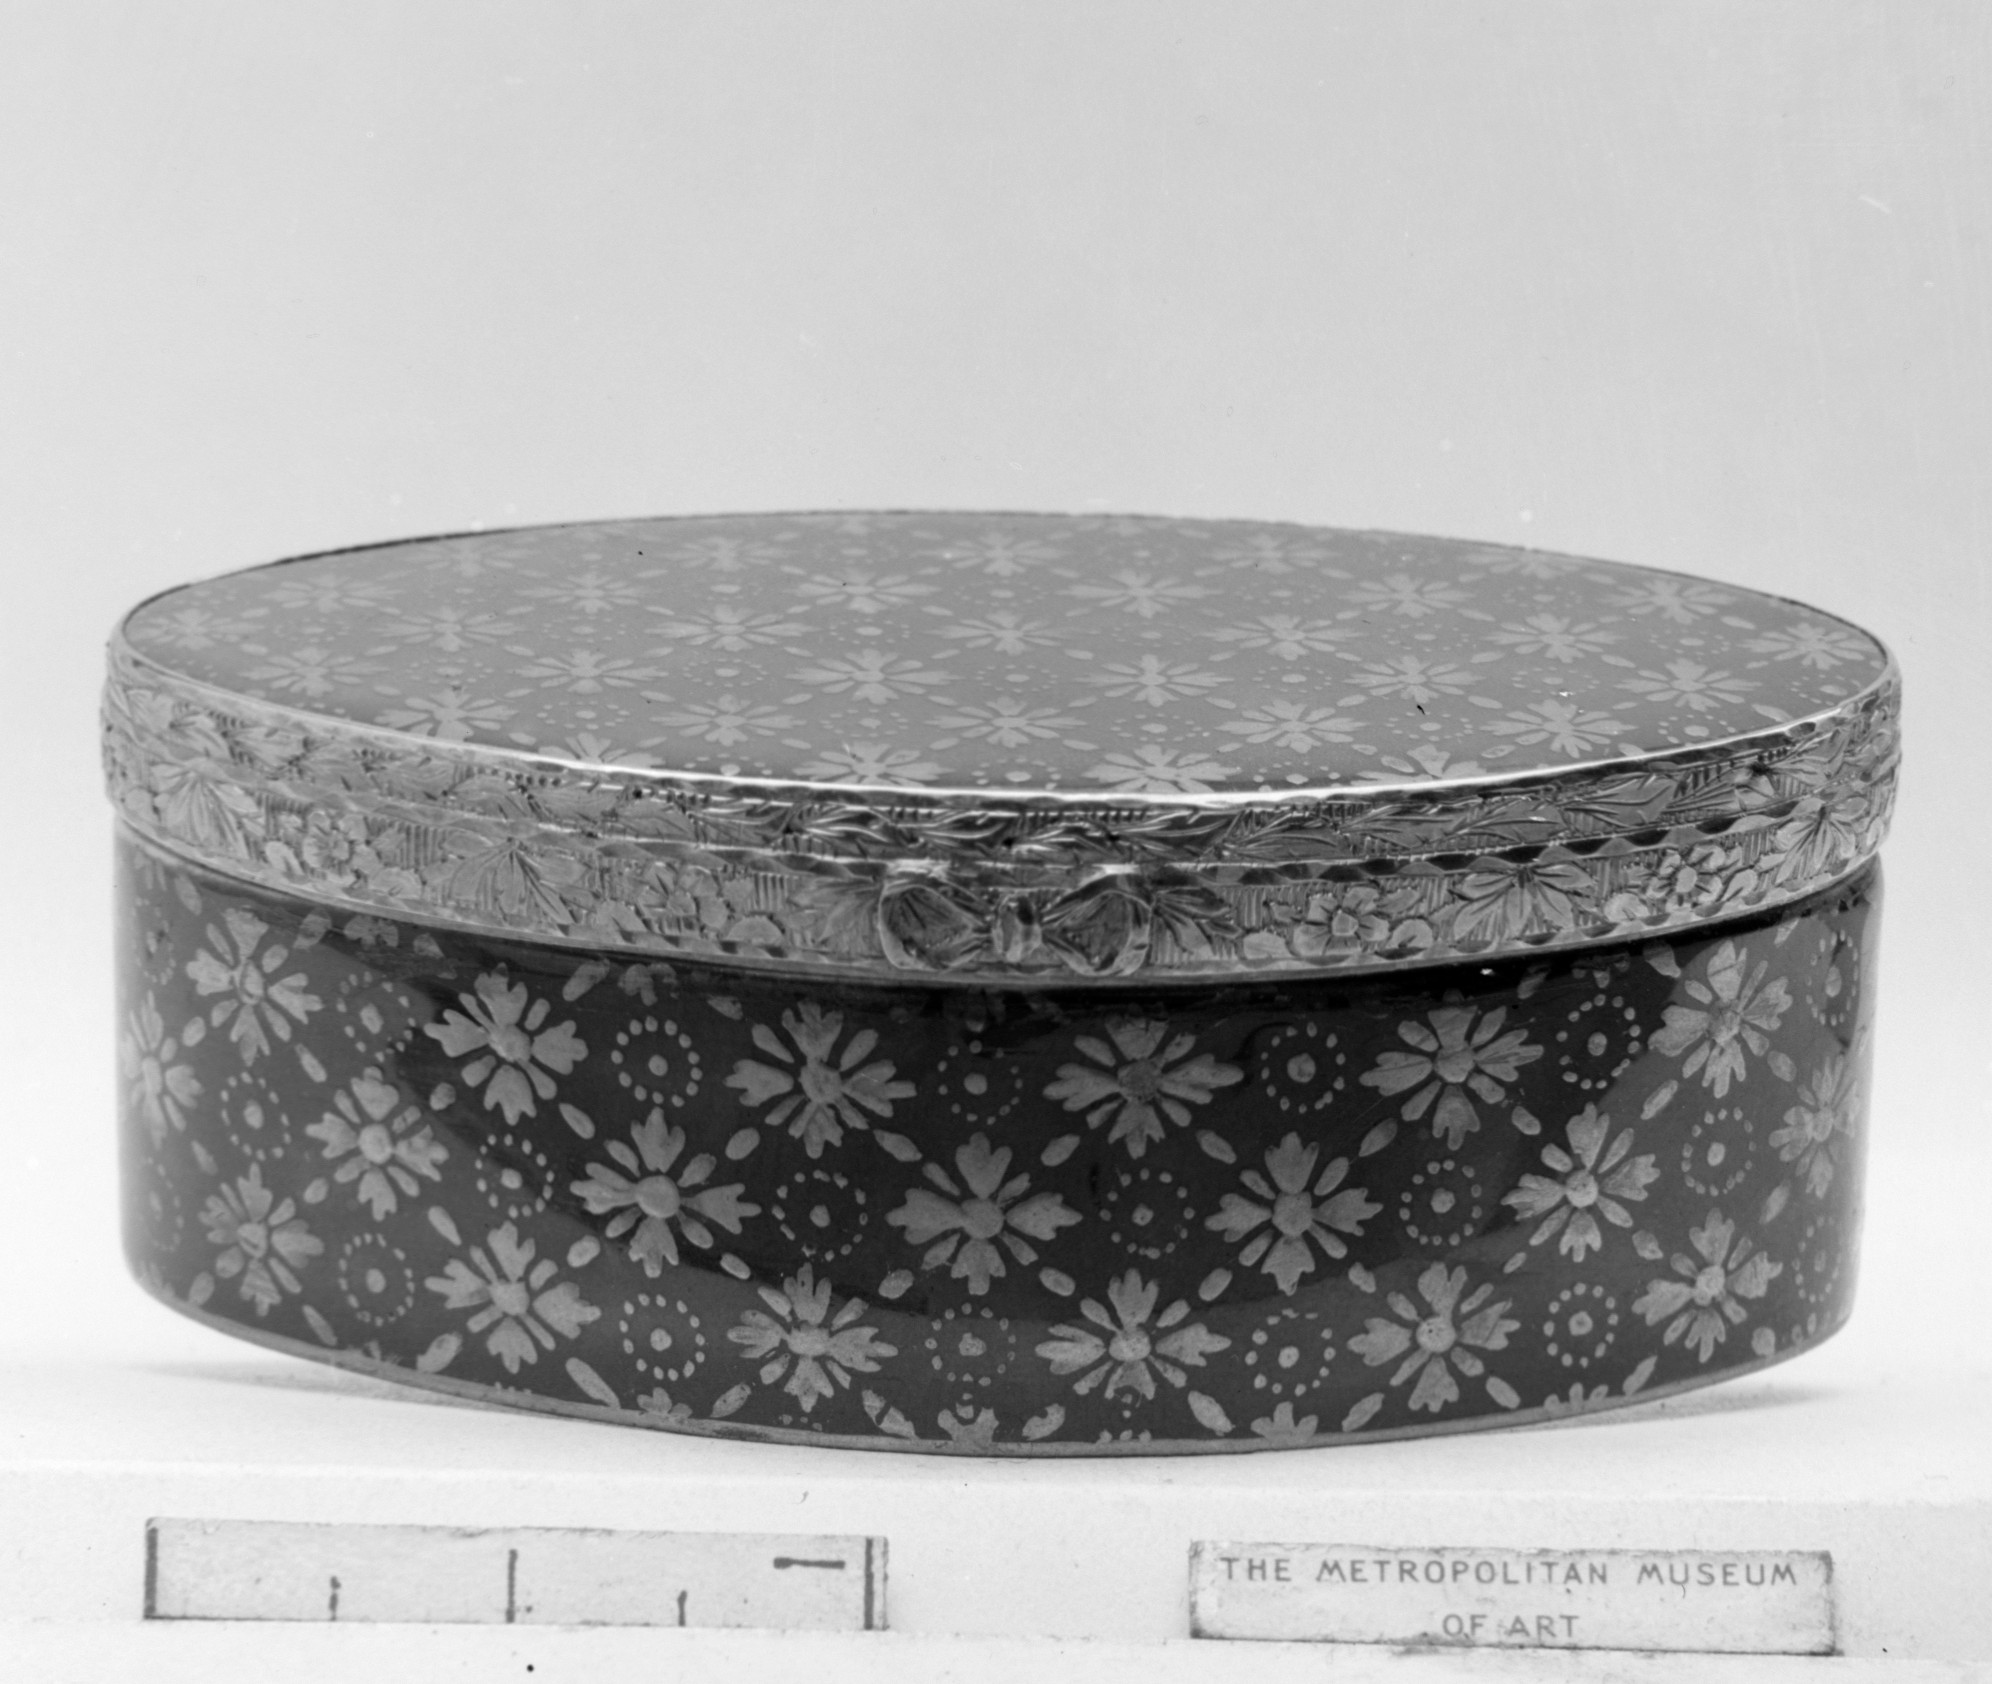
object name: snuffbox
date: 1785-1790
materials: enamel, gold, porcelain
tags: flowers